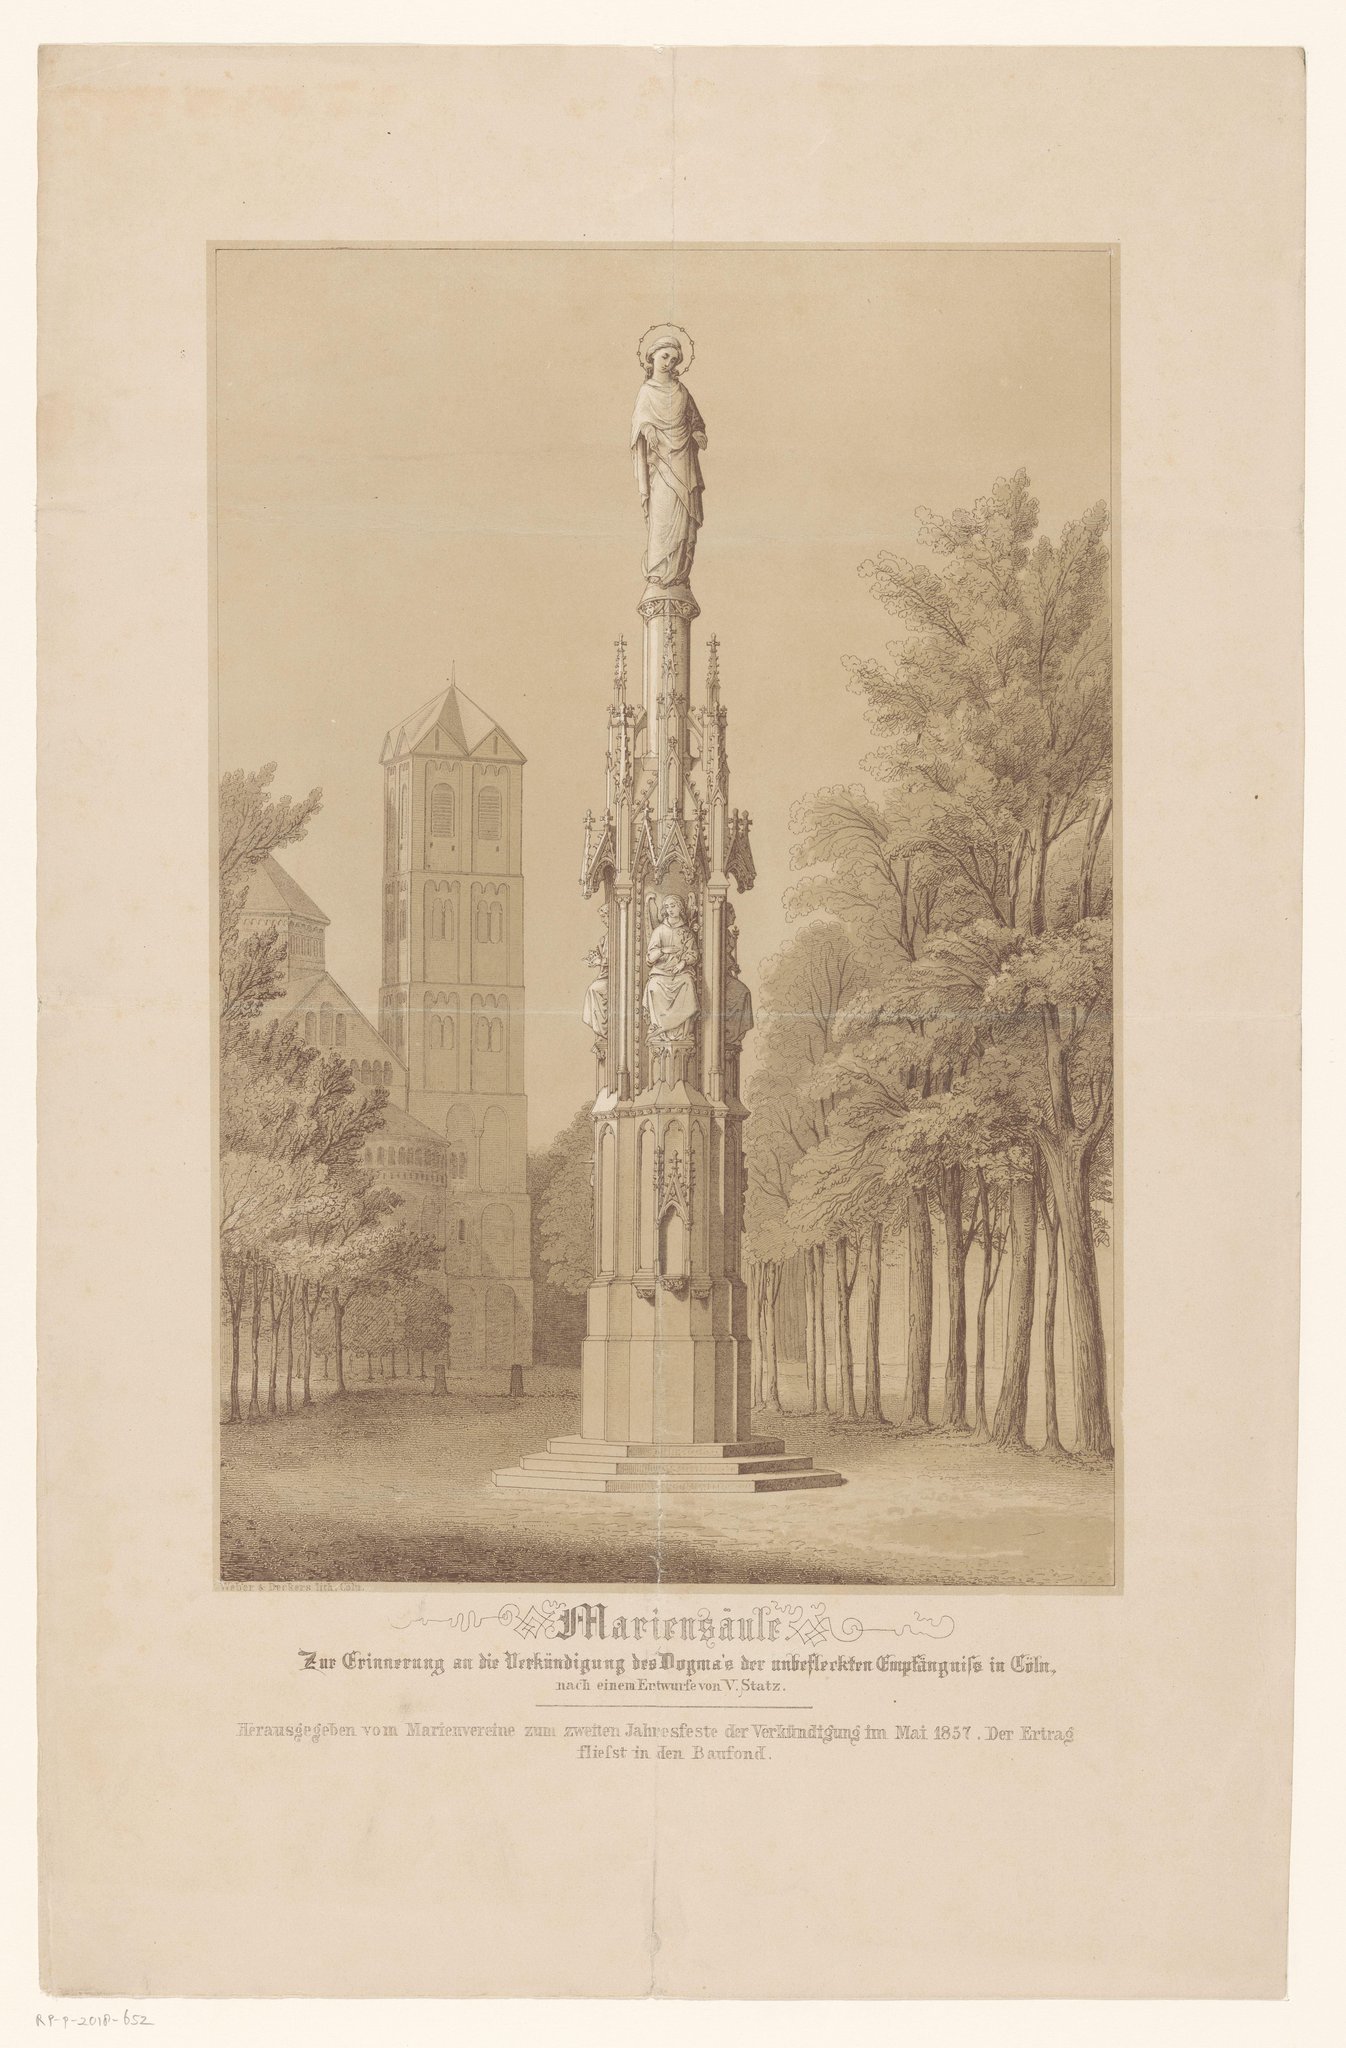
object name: print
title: Mariensäule. Zur Erinnerrung an die Verkündigung des Dogma's der unbefleckten Empfängniß in Cöln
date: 1805-1857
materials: paper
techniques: tone lithography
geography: cologne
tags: monument, statue, mary devotion, cologne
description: Ontwerp voor de Mariazuil in Keulen, uitgave bij de viering van het tweede jaarfeest in mei 1857 van het dogma van de Onbevlekte Ontvangenis verkondigd door paus Pius IX. Het beeld werd in 1858 geplaatst.